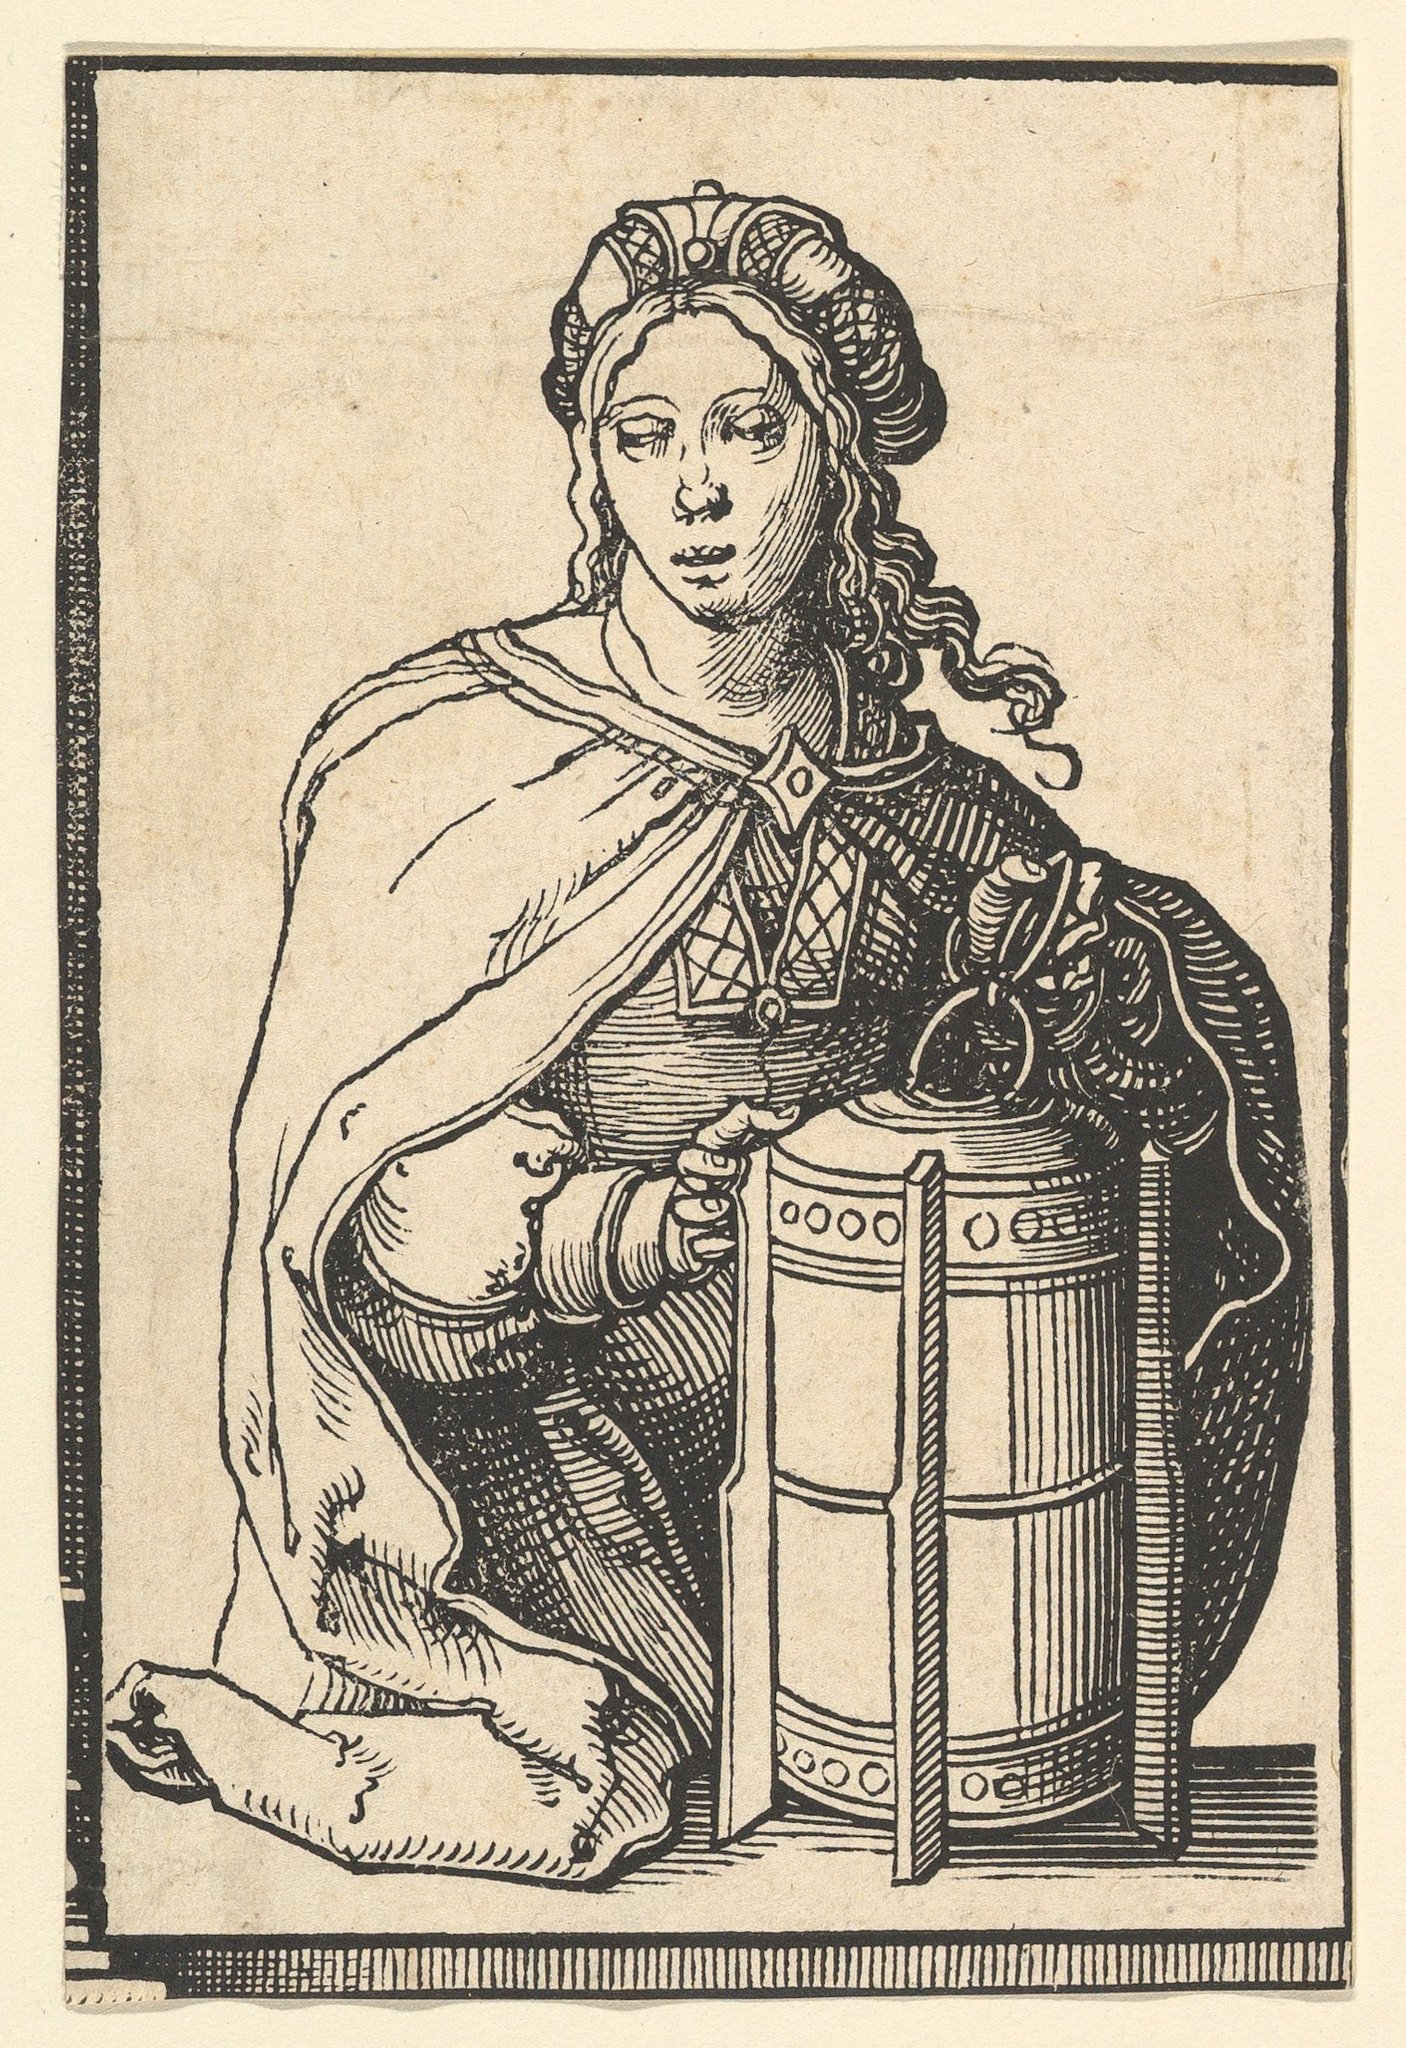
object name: print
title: Persian Sibyl, from the series of Sibyls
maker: lucas van leyden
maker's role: artist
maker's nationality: netherlandish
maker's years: 1494-1533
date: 1530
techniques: woodcut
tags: portraits,sibyl